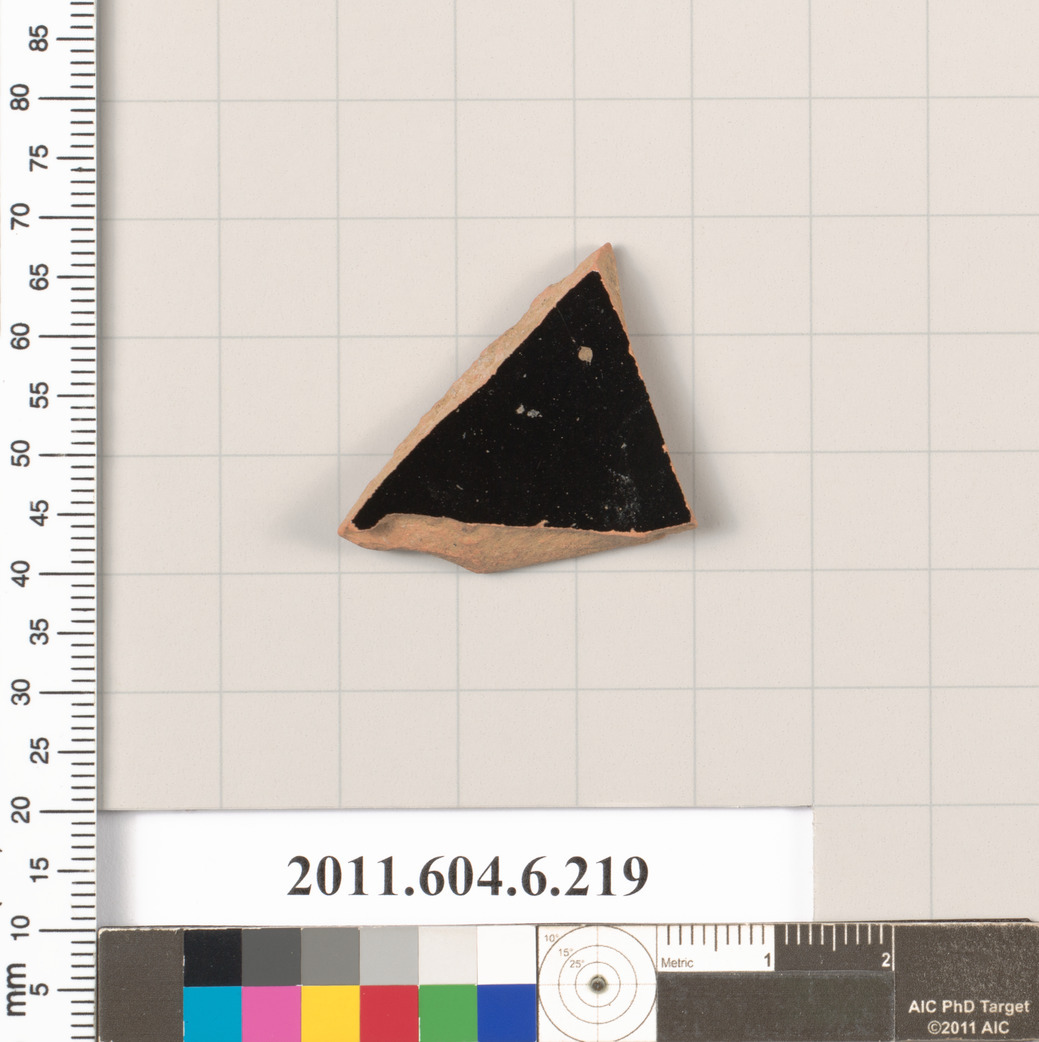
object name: undetermined open shape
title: Terracotta fragment of an open shape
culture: greek, attic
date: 600-401 BCE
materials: terracotta